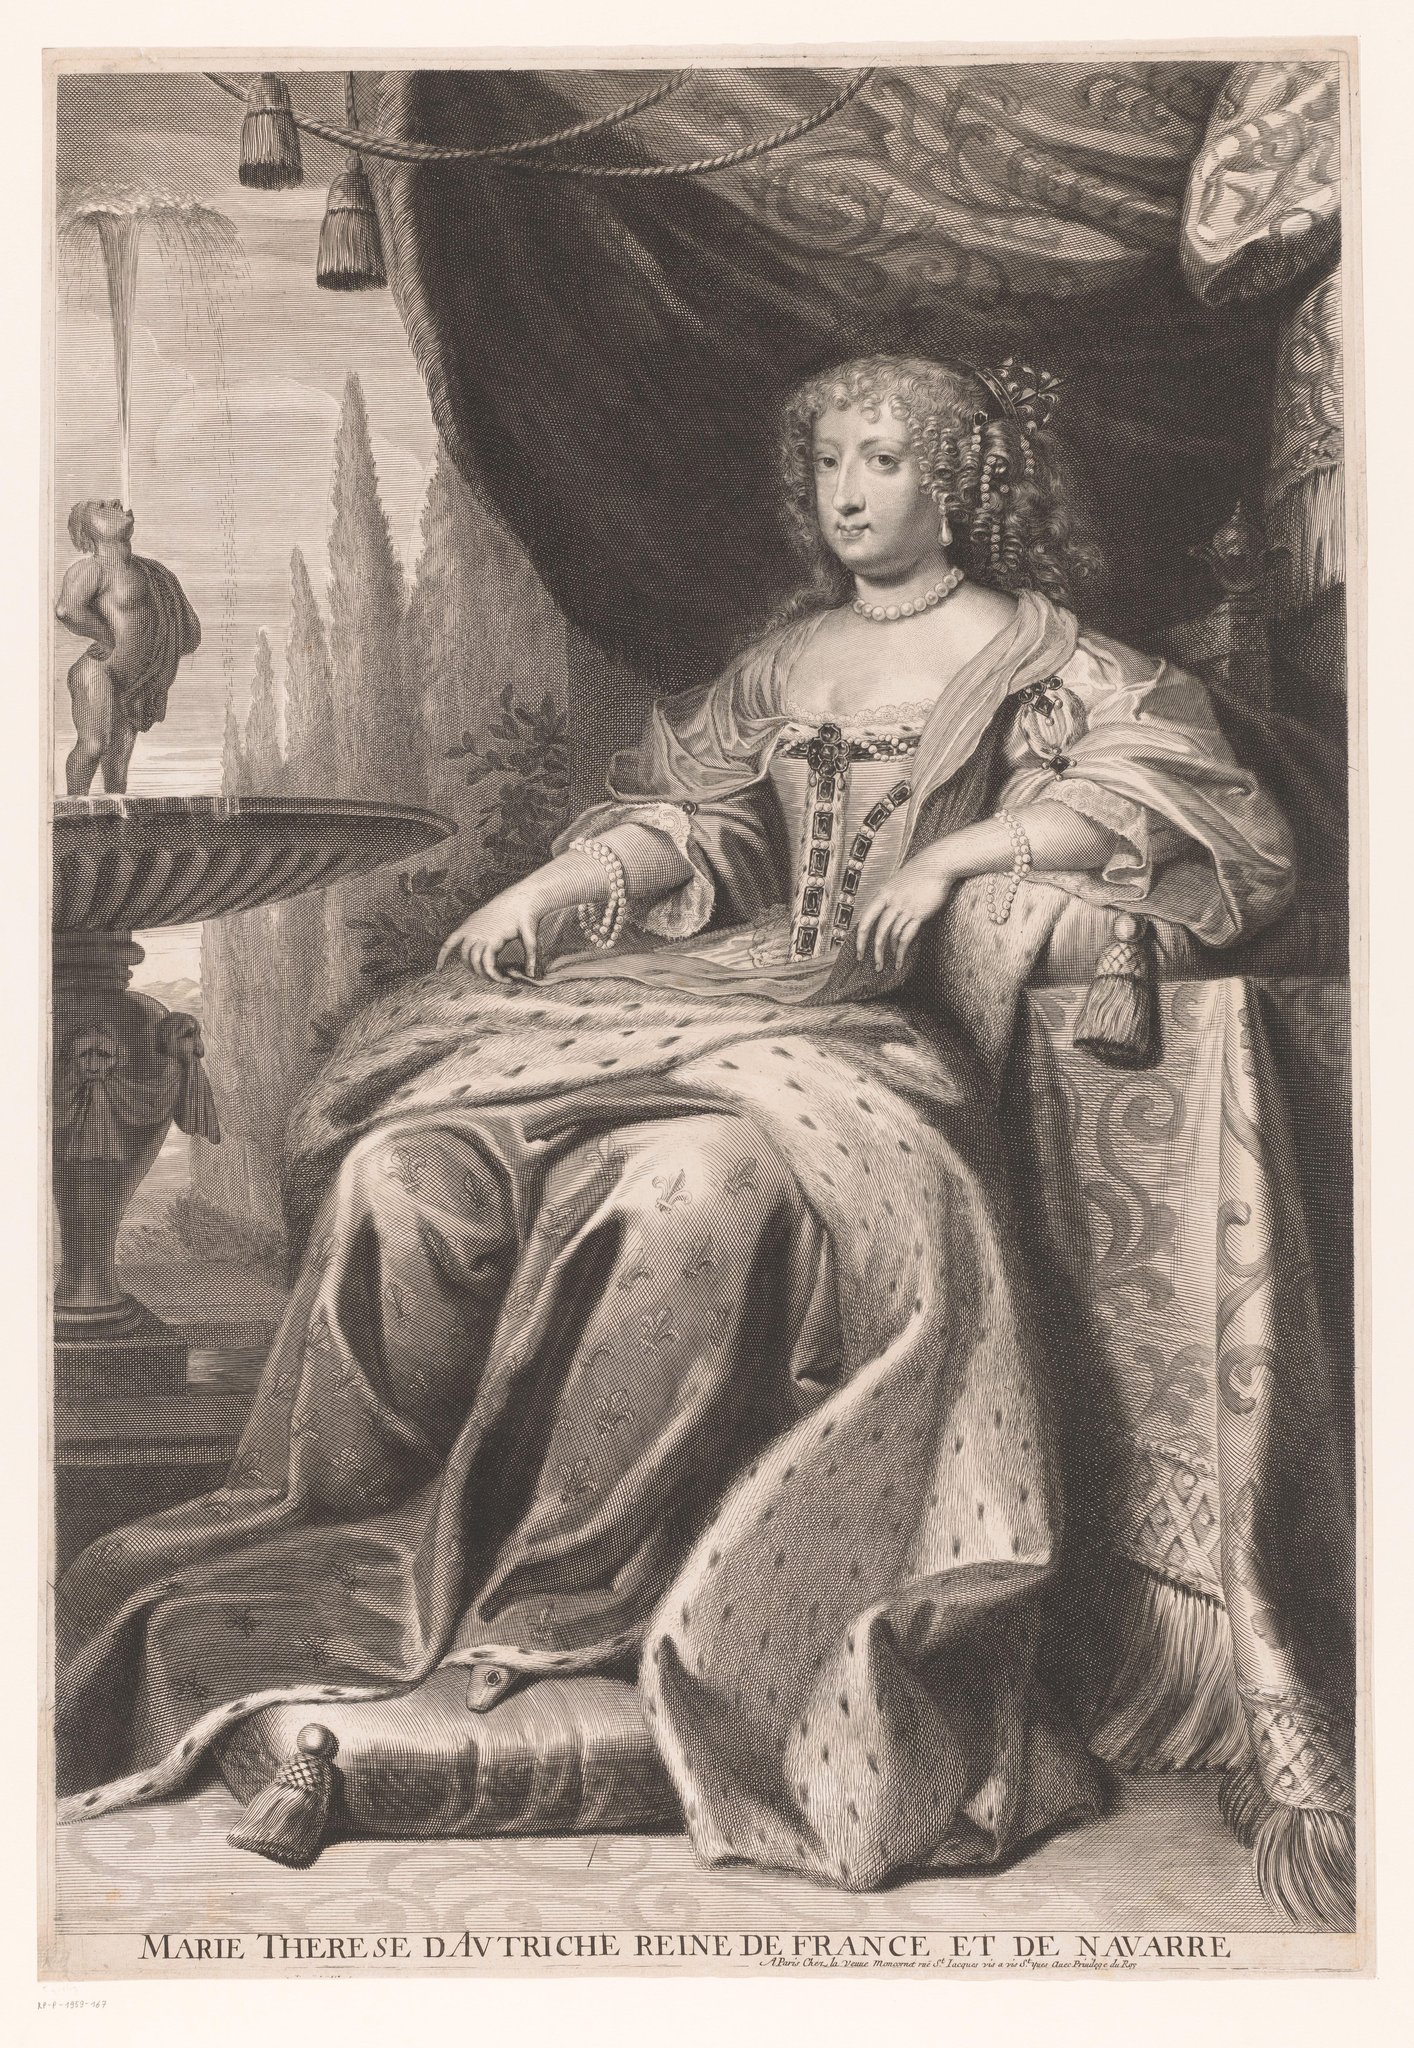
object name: print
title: Maria Theresia van Oostenrijk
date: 1660-1683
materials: paper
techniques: engraving, etching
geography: paris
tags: maria theresia (koningin van frankrijk), historical persons - bb - woman, queen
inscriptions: collector's mark: Lugt 2228, collector's mark: Lugt 2760